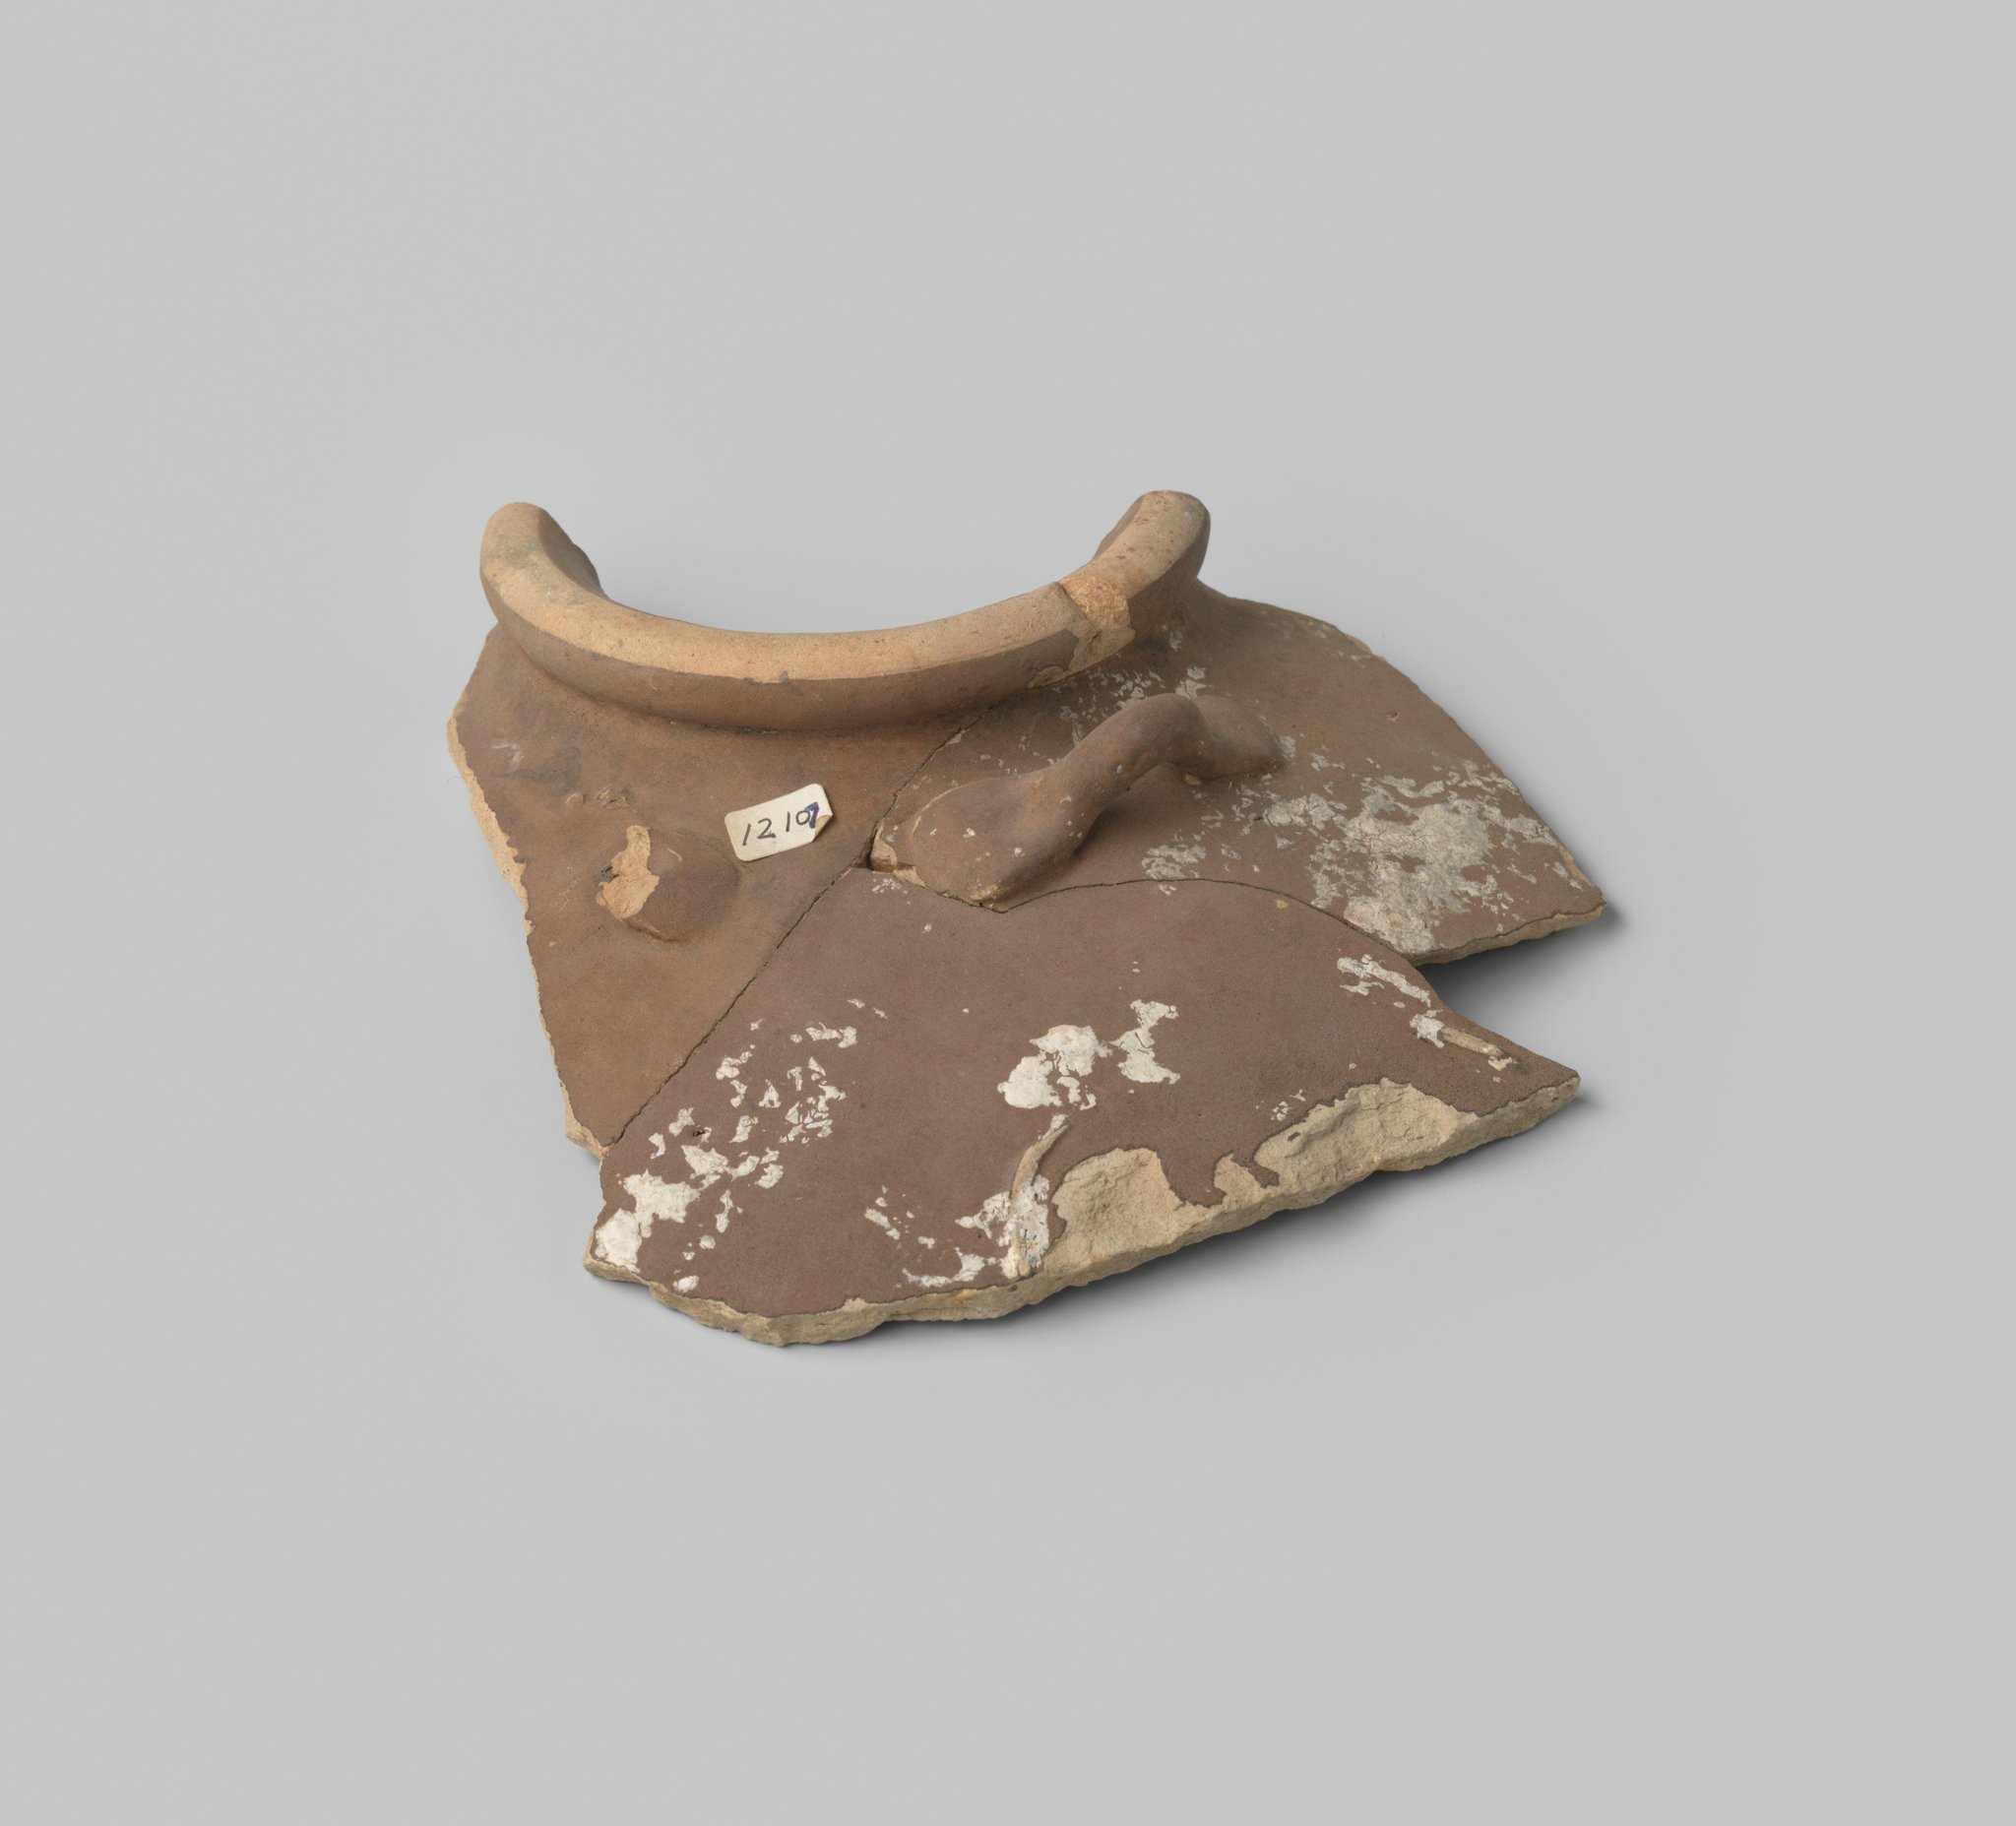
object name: sherd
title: Fragment martavaan uit V.O.C.-schip de 'Witte Leeuw'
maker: Anonymous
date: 1613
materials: porcelain, stoneware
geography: south china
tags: verenigde oostindische compagnie, sint-helena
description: A jar. The jar is high-shouldered and has a cream coloured body with a few black specks. The glaze is of a chocolate brown colour. Between two ears is a square mark. The lip-rim, shoulder and lower part of the jar is undamaged.